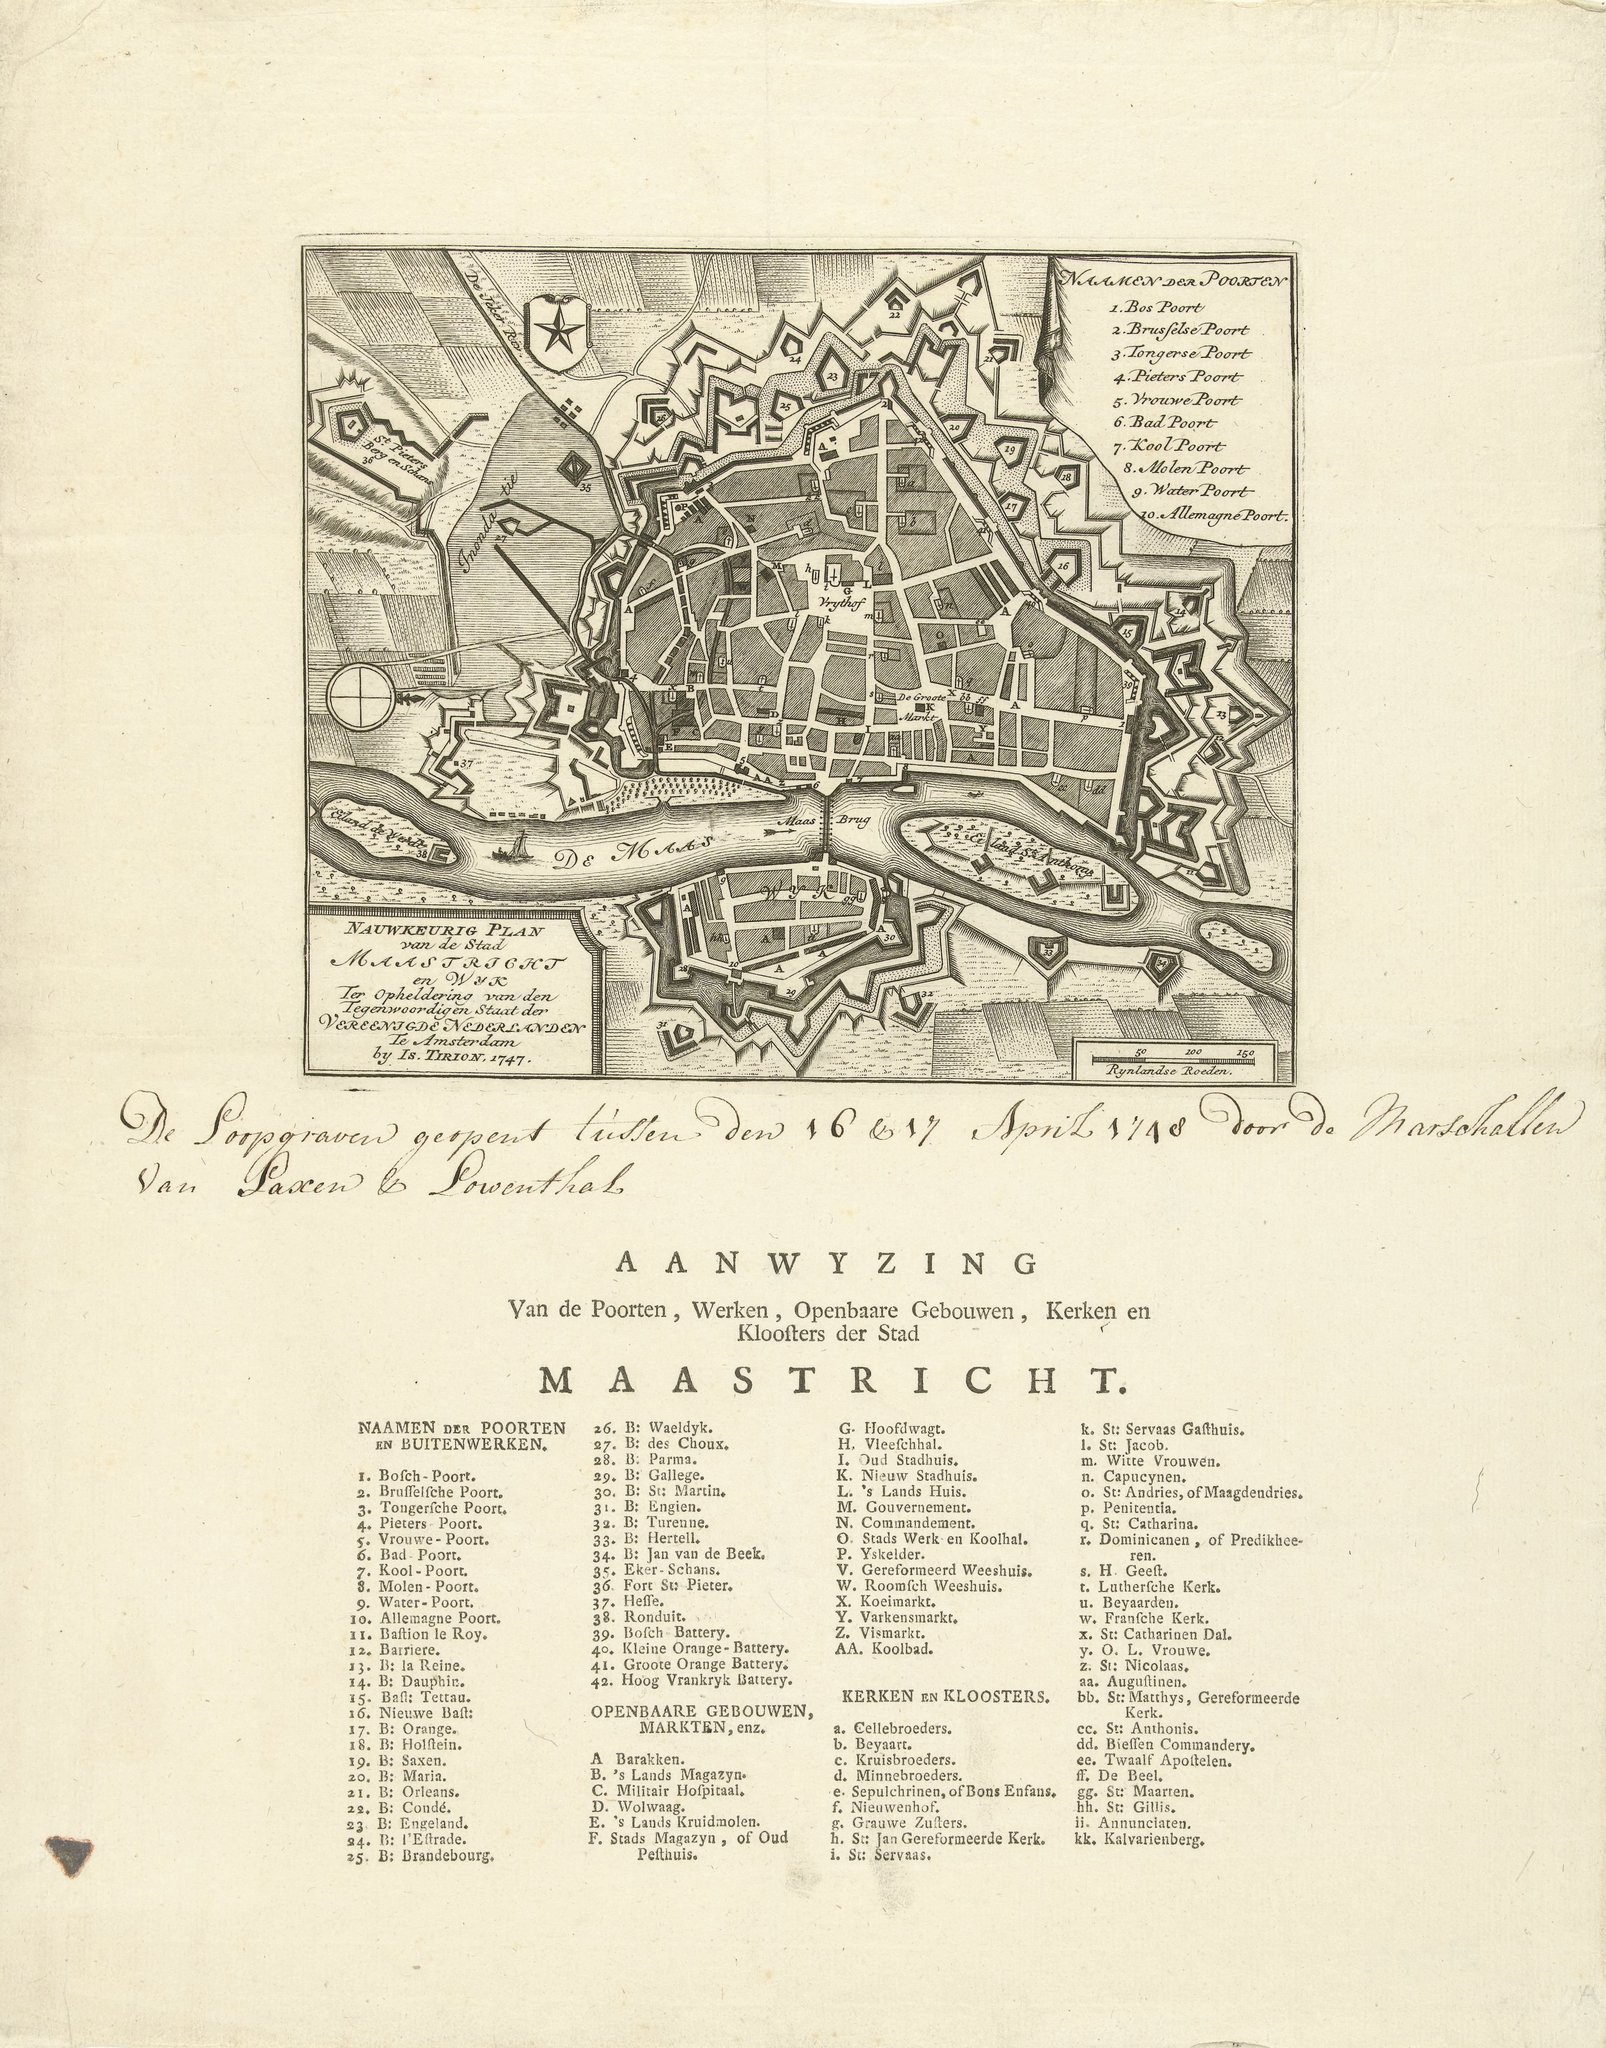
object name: print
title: Nauwkeurig Plan van de Stad Maastricht en Wyk Ter Opheldering van den Tegenwoordigen Staat der vereenigde Nederlanden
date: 1747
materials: paper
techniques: etching, letterpress printing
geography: northern netherlands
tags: fortress, maps of cities, maastricht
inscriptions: collector's mark: Lugt 2228, inscription: ‘De Loopgraven geopent tussen den 16 & 17 April 1748 door de Maarschalken Van Saxen & Lowenthal’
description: Plan van Maastricht met de verdedigingswerken om de stad in het jaar 1747. Rechtsboven een cartouche met de legenda voor de poorten van de stad genummerd 1-10. De plattegrond hier opgenomen in verband met het beleg van de stad door de Fransen onder Maurits van Saksen en Lowendal vanaf 15 april en ingenomen op 7 mei 1748. Op het blad onder de plaat de legenda 1-42, A-AA en a-kk in het Nederlands.